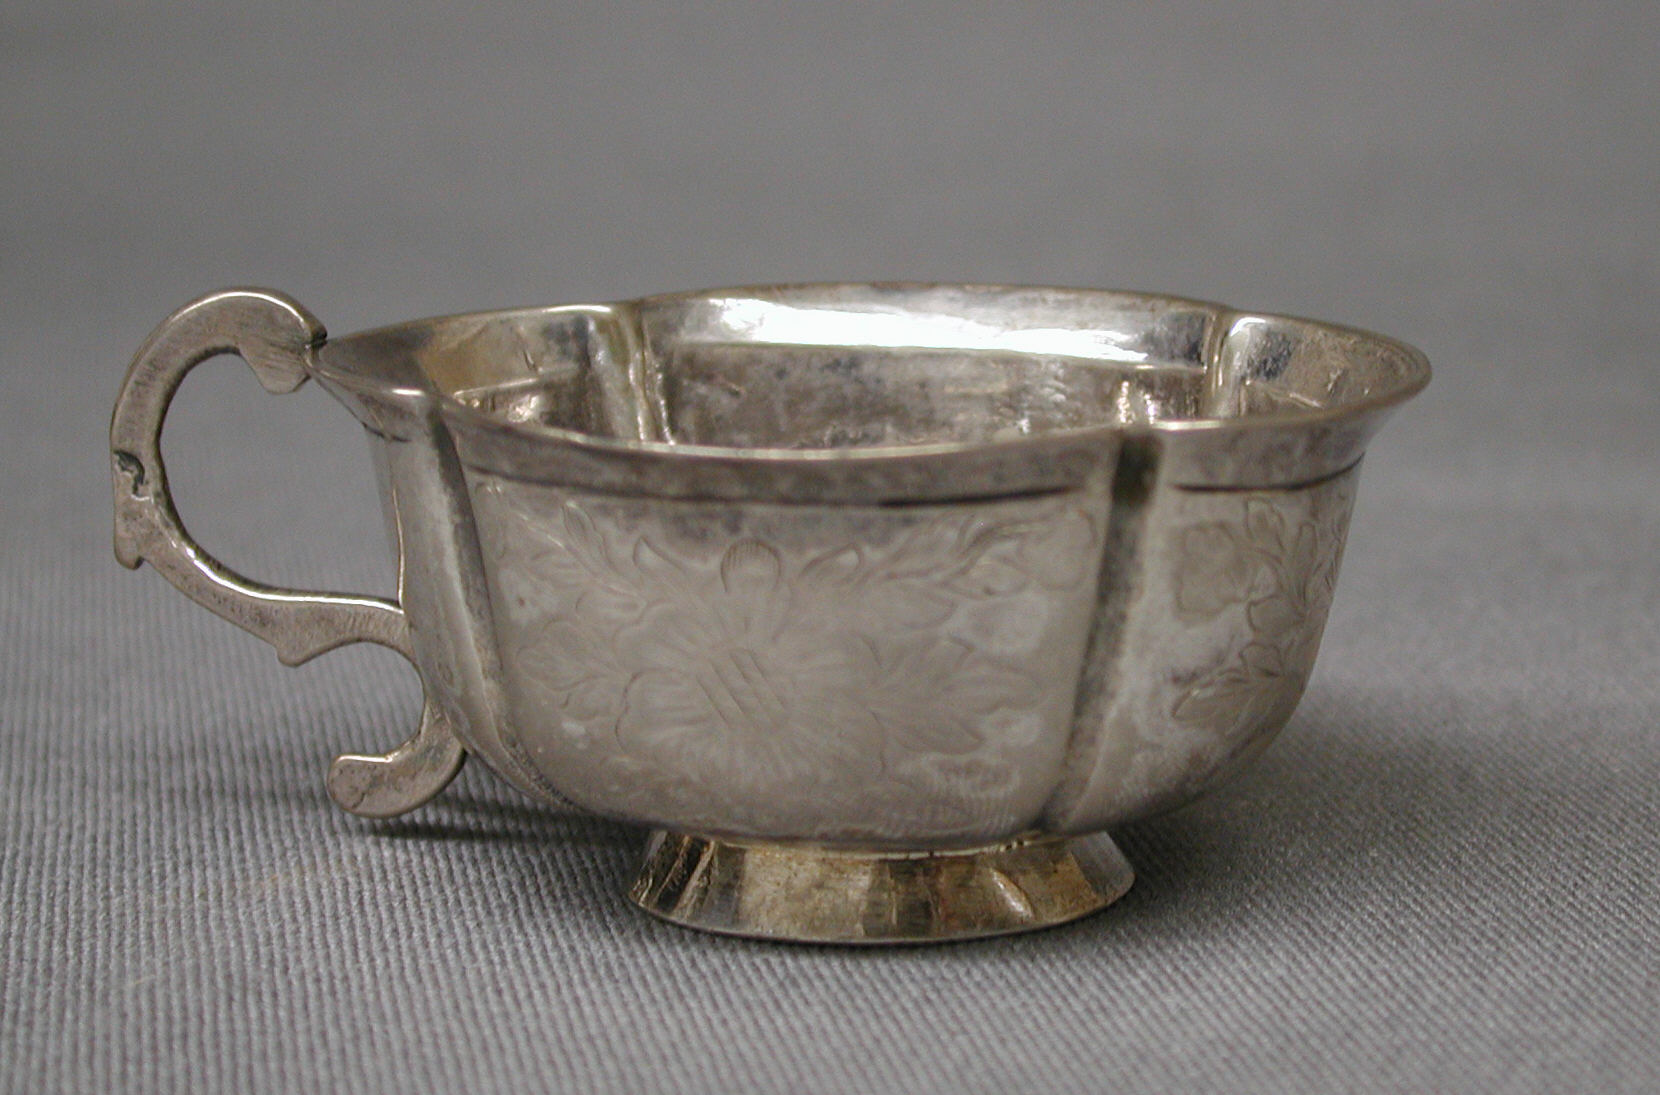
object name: cup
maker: f.g.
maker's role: artist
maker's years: 1700-1800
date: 1777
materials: silver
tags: flowers